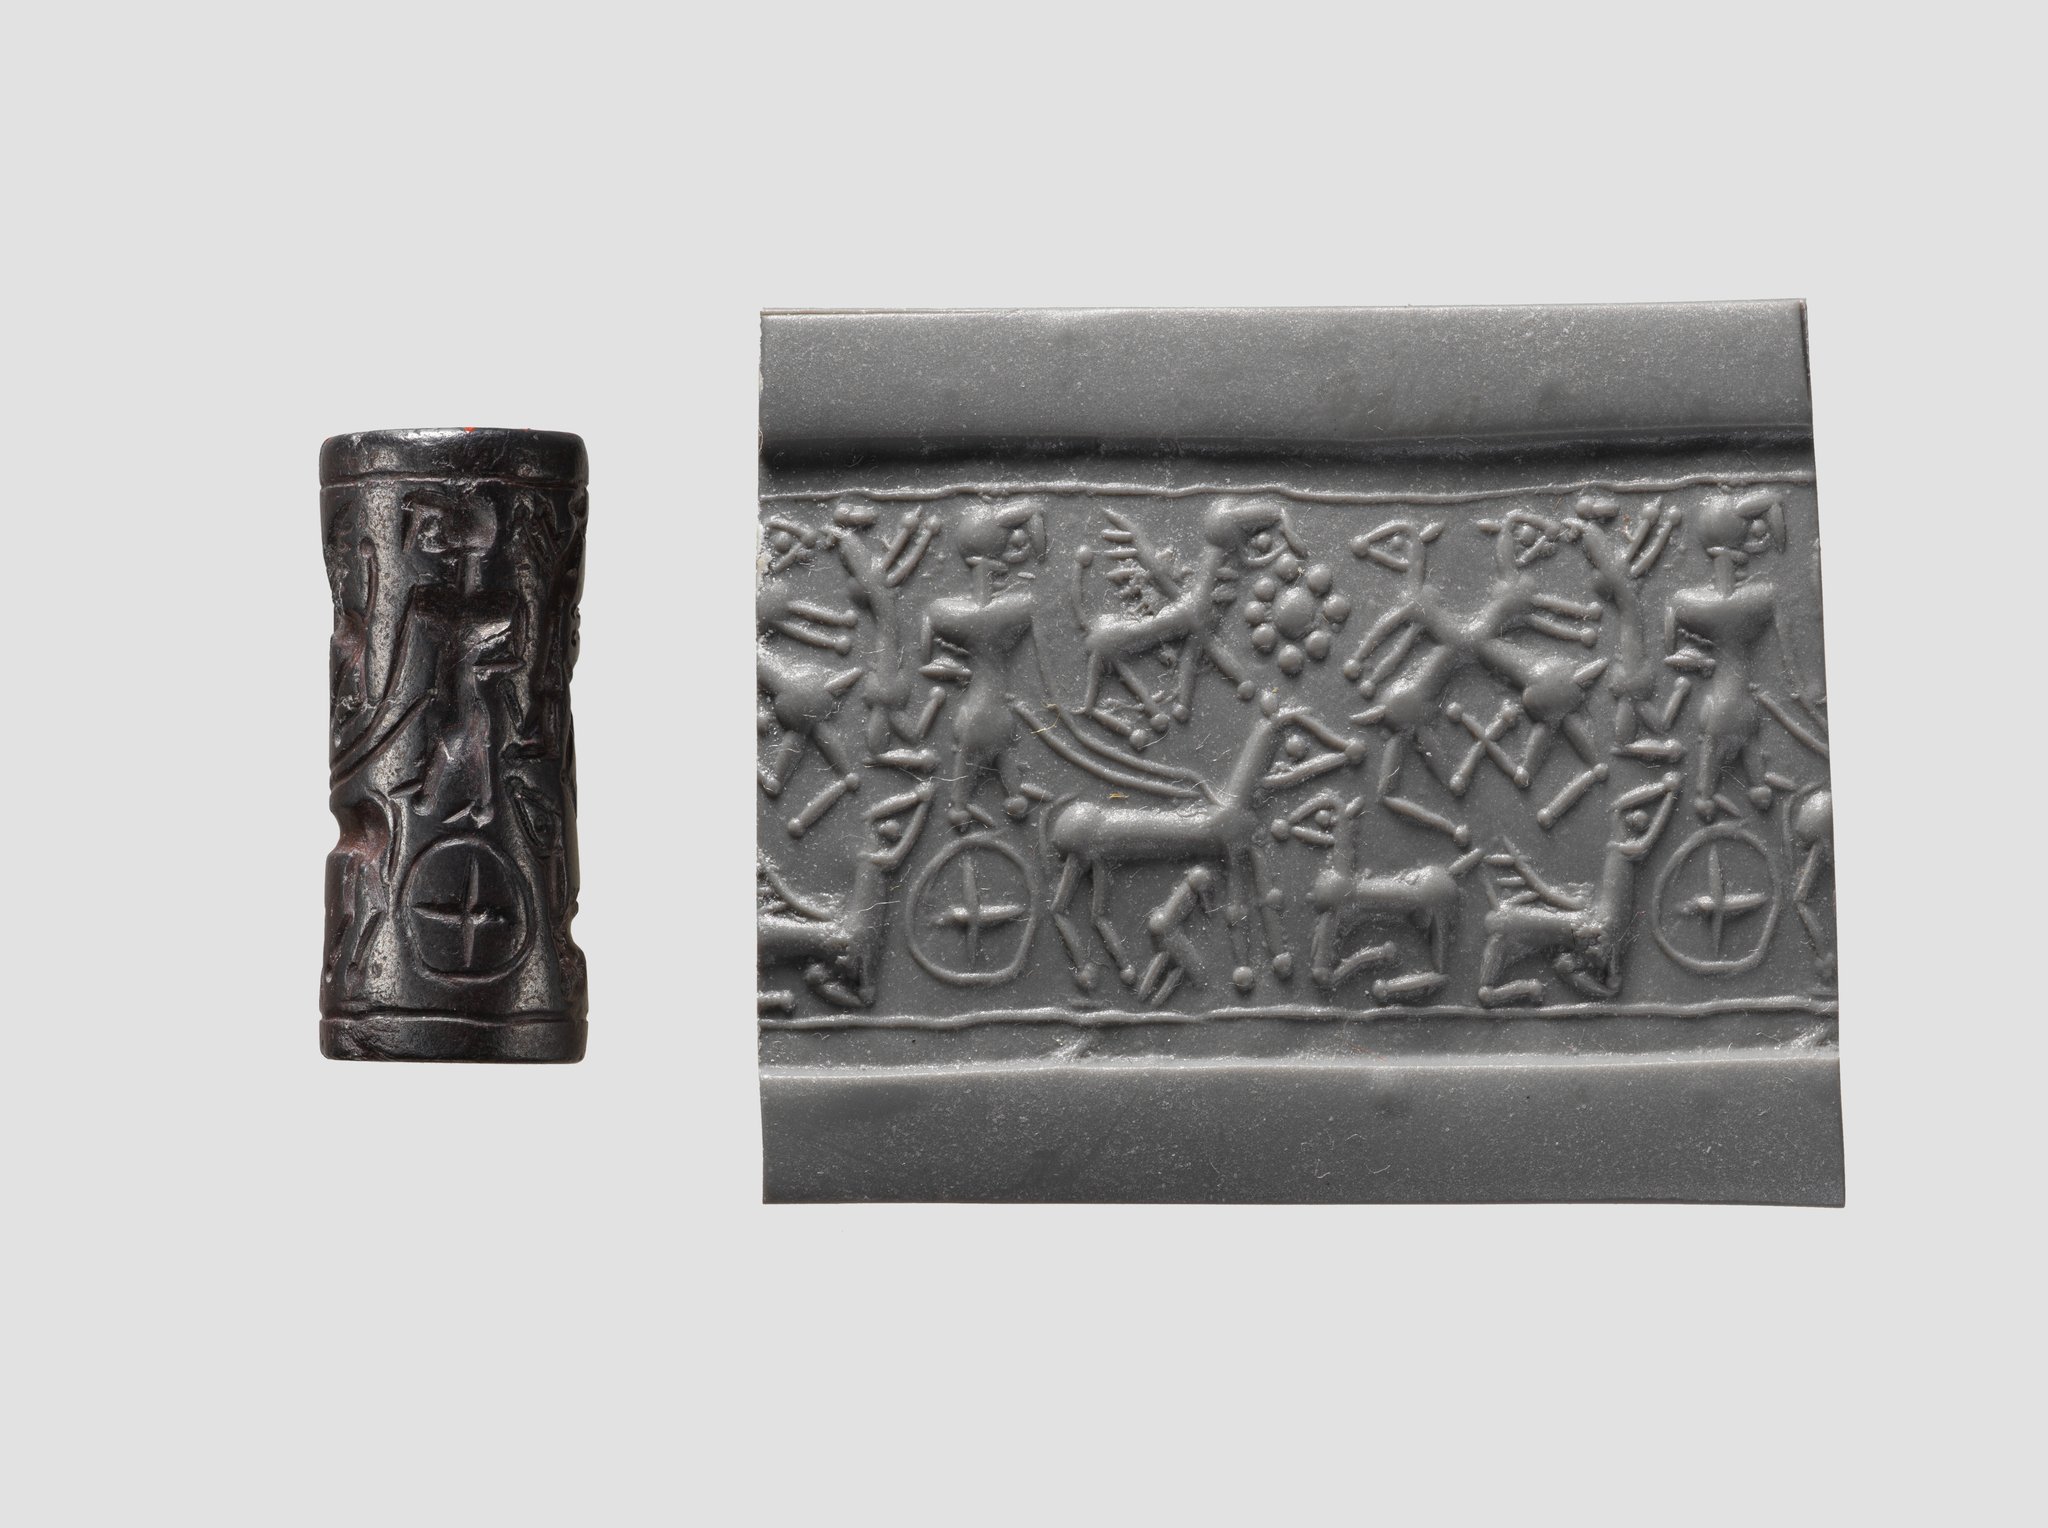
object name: cylinder seal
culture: cypriot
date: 1600-1201 BCE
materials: mineral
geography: cyprus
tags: animals